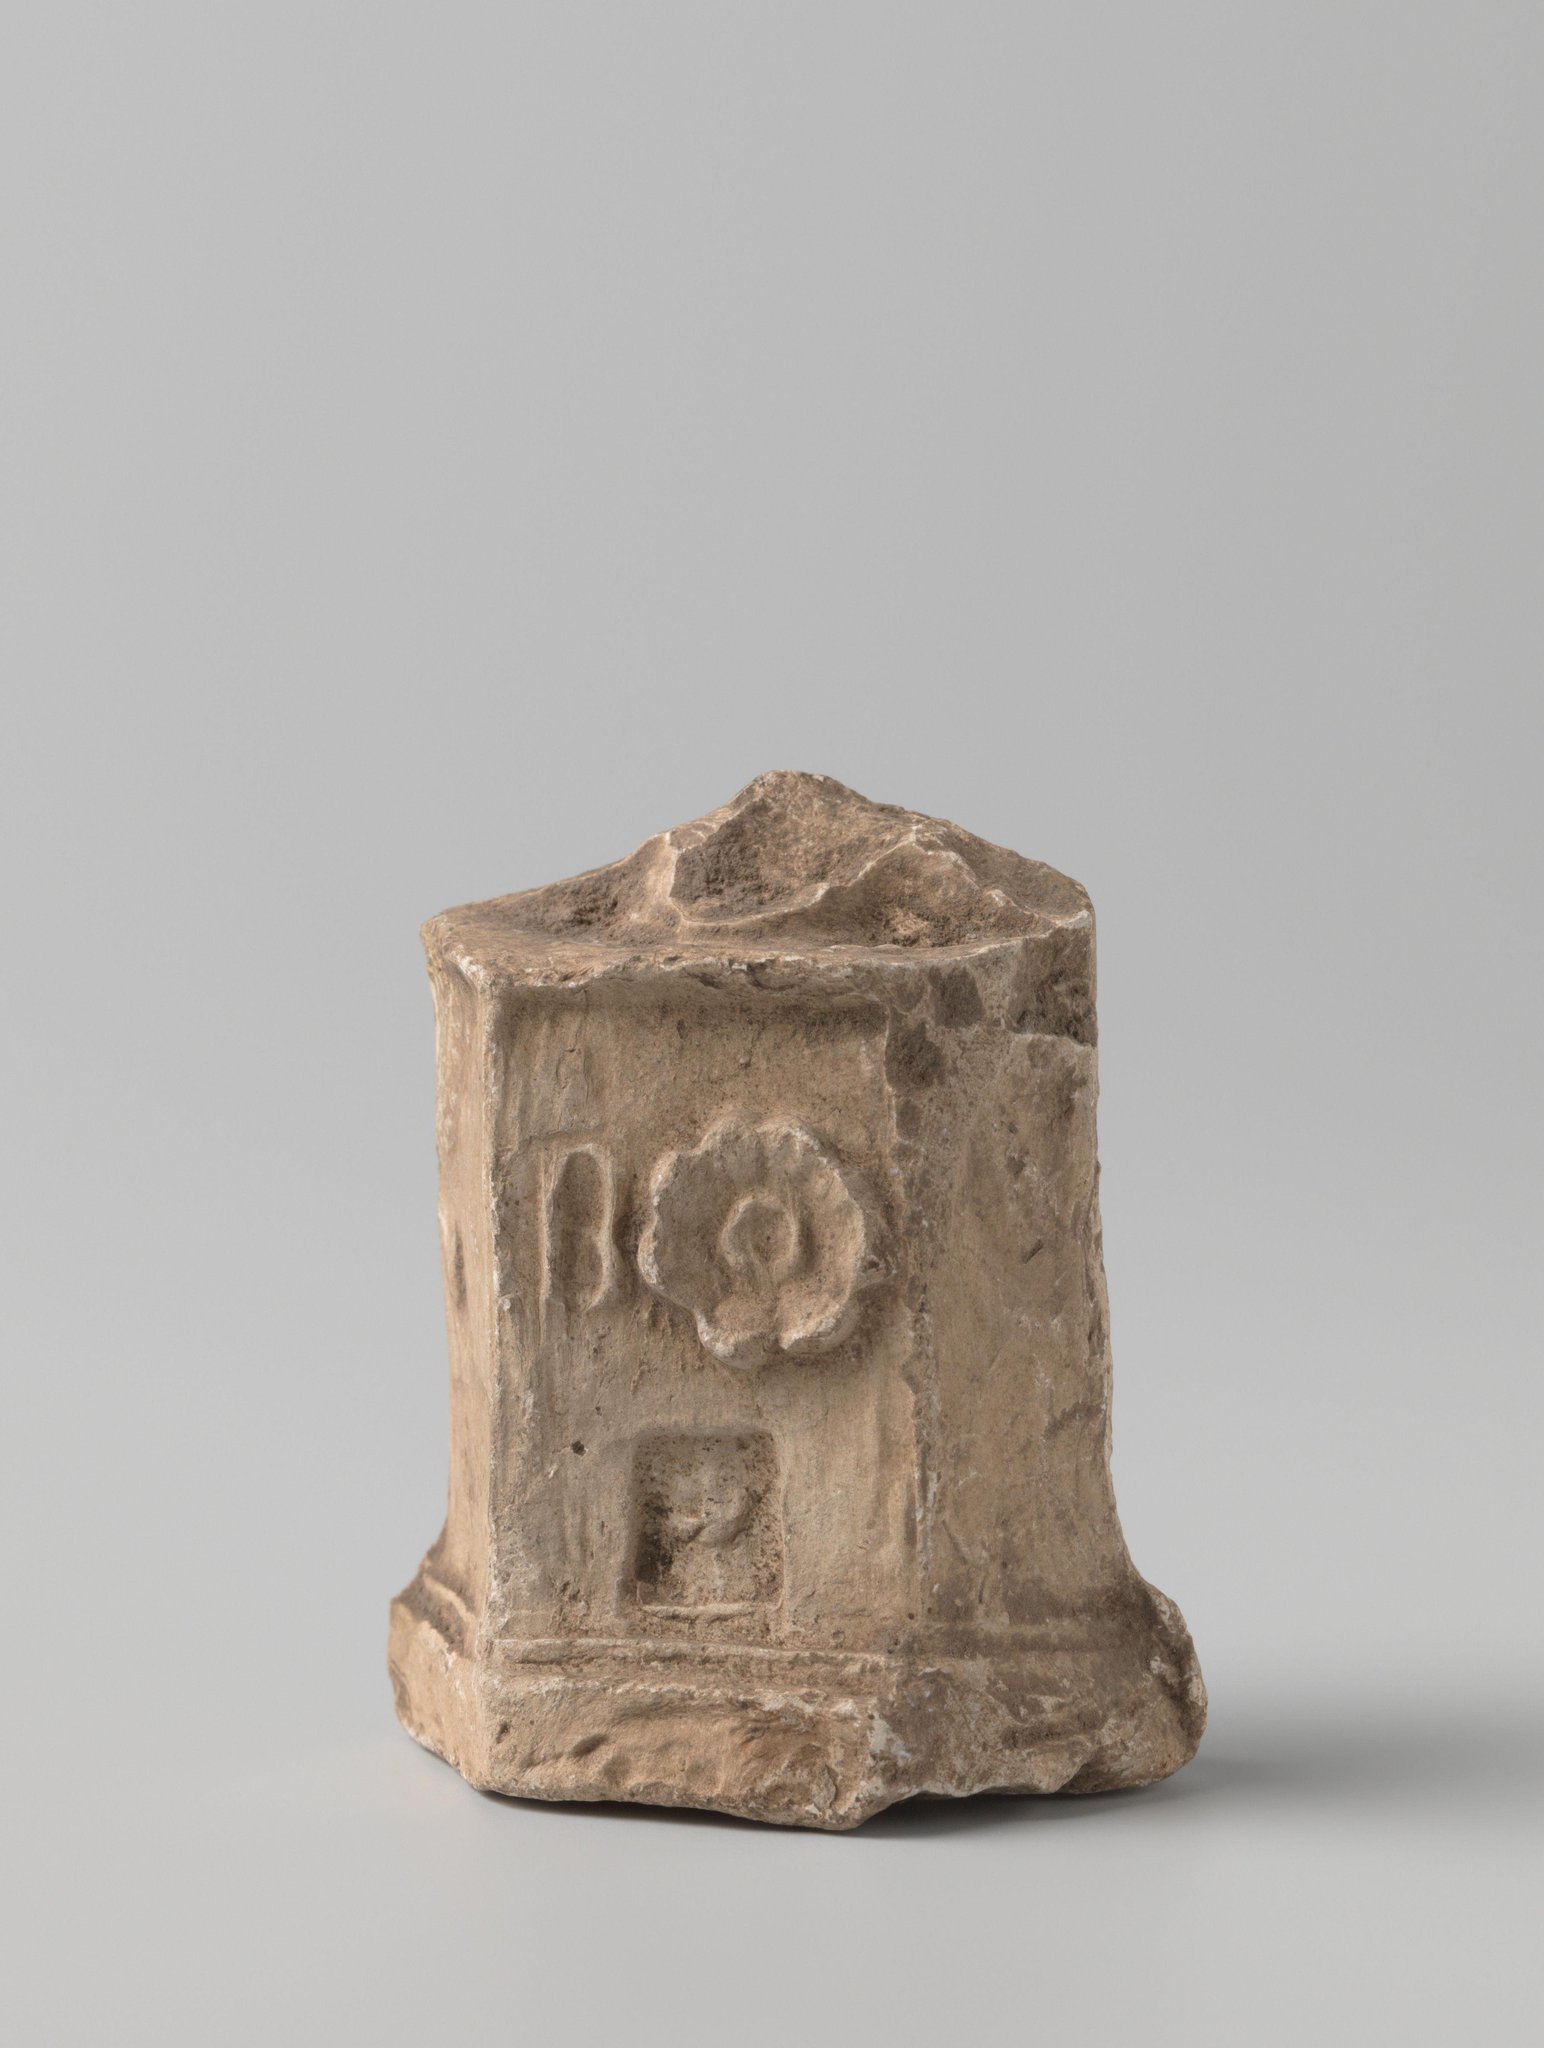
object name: pedestal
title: Sokkel van een beeldhouwwerk.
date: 1400-1950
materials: earthenware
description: Sokkel of voetstuk van een beeldhouwwerk. De sokkel is gemerkt met de letter B en een rozet of bloem.